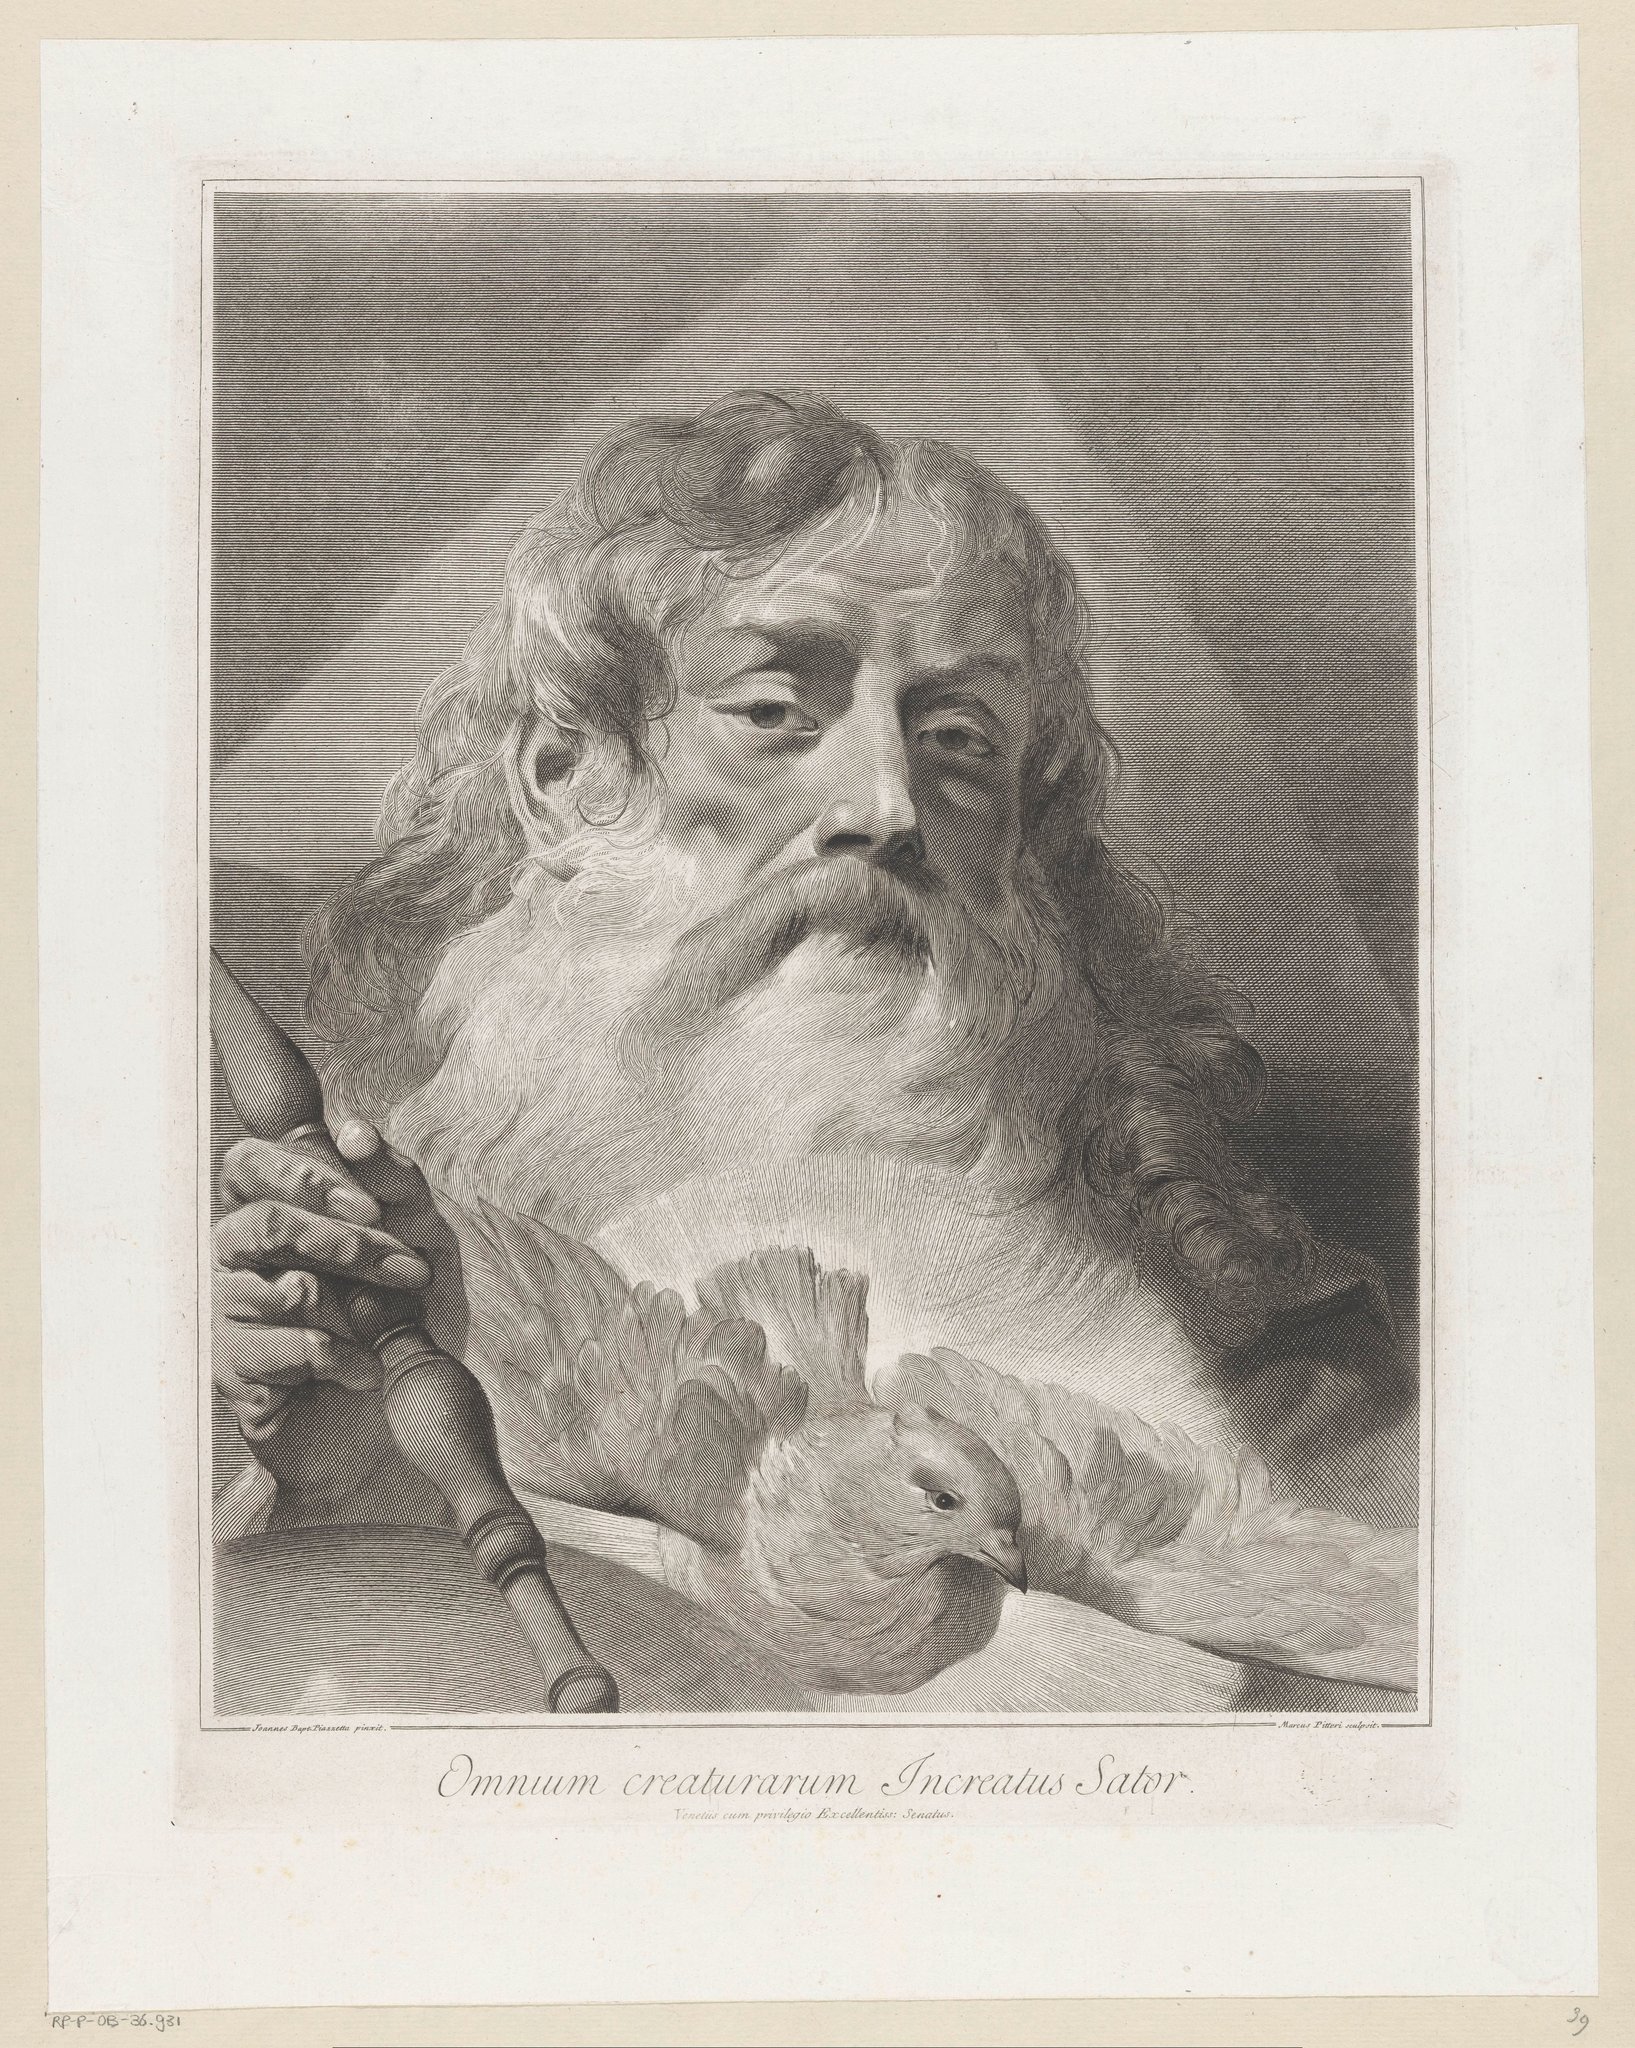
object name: print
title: Omnum creaturarum Increatus Sator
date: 1712-1786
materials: paper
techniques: engraving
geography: venice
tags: god the father, symbols of god the father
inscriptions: collector's mark: Lugt 240